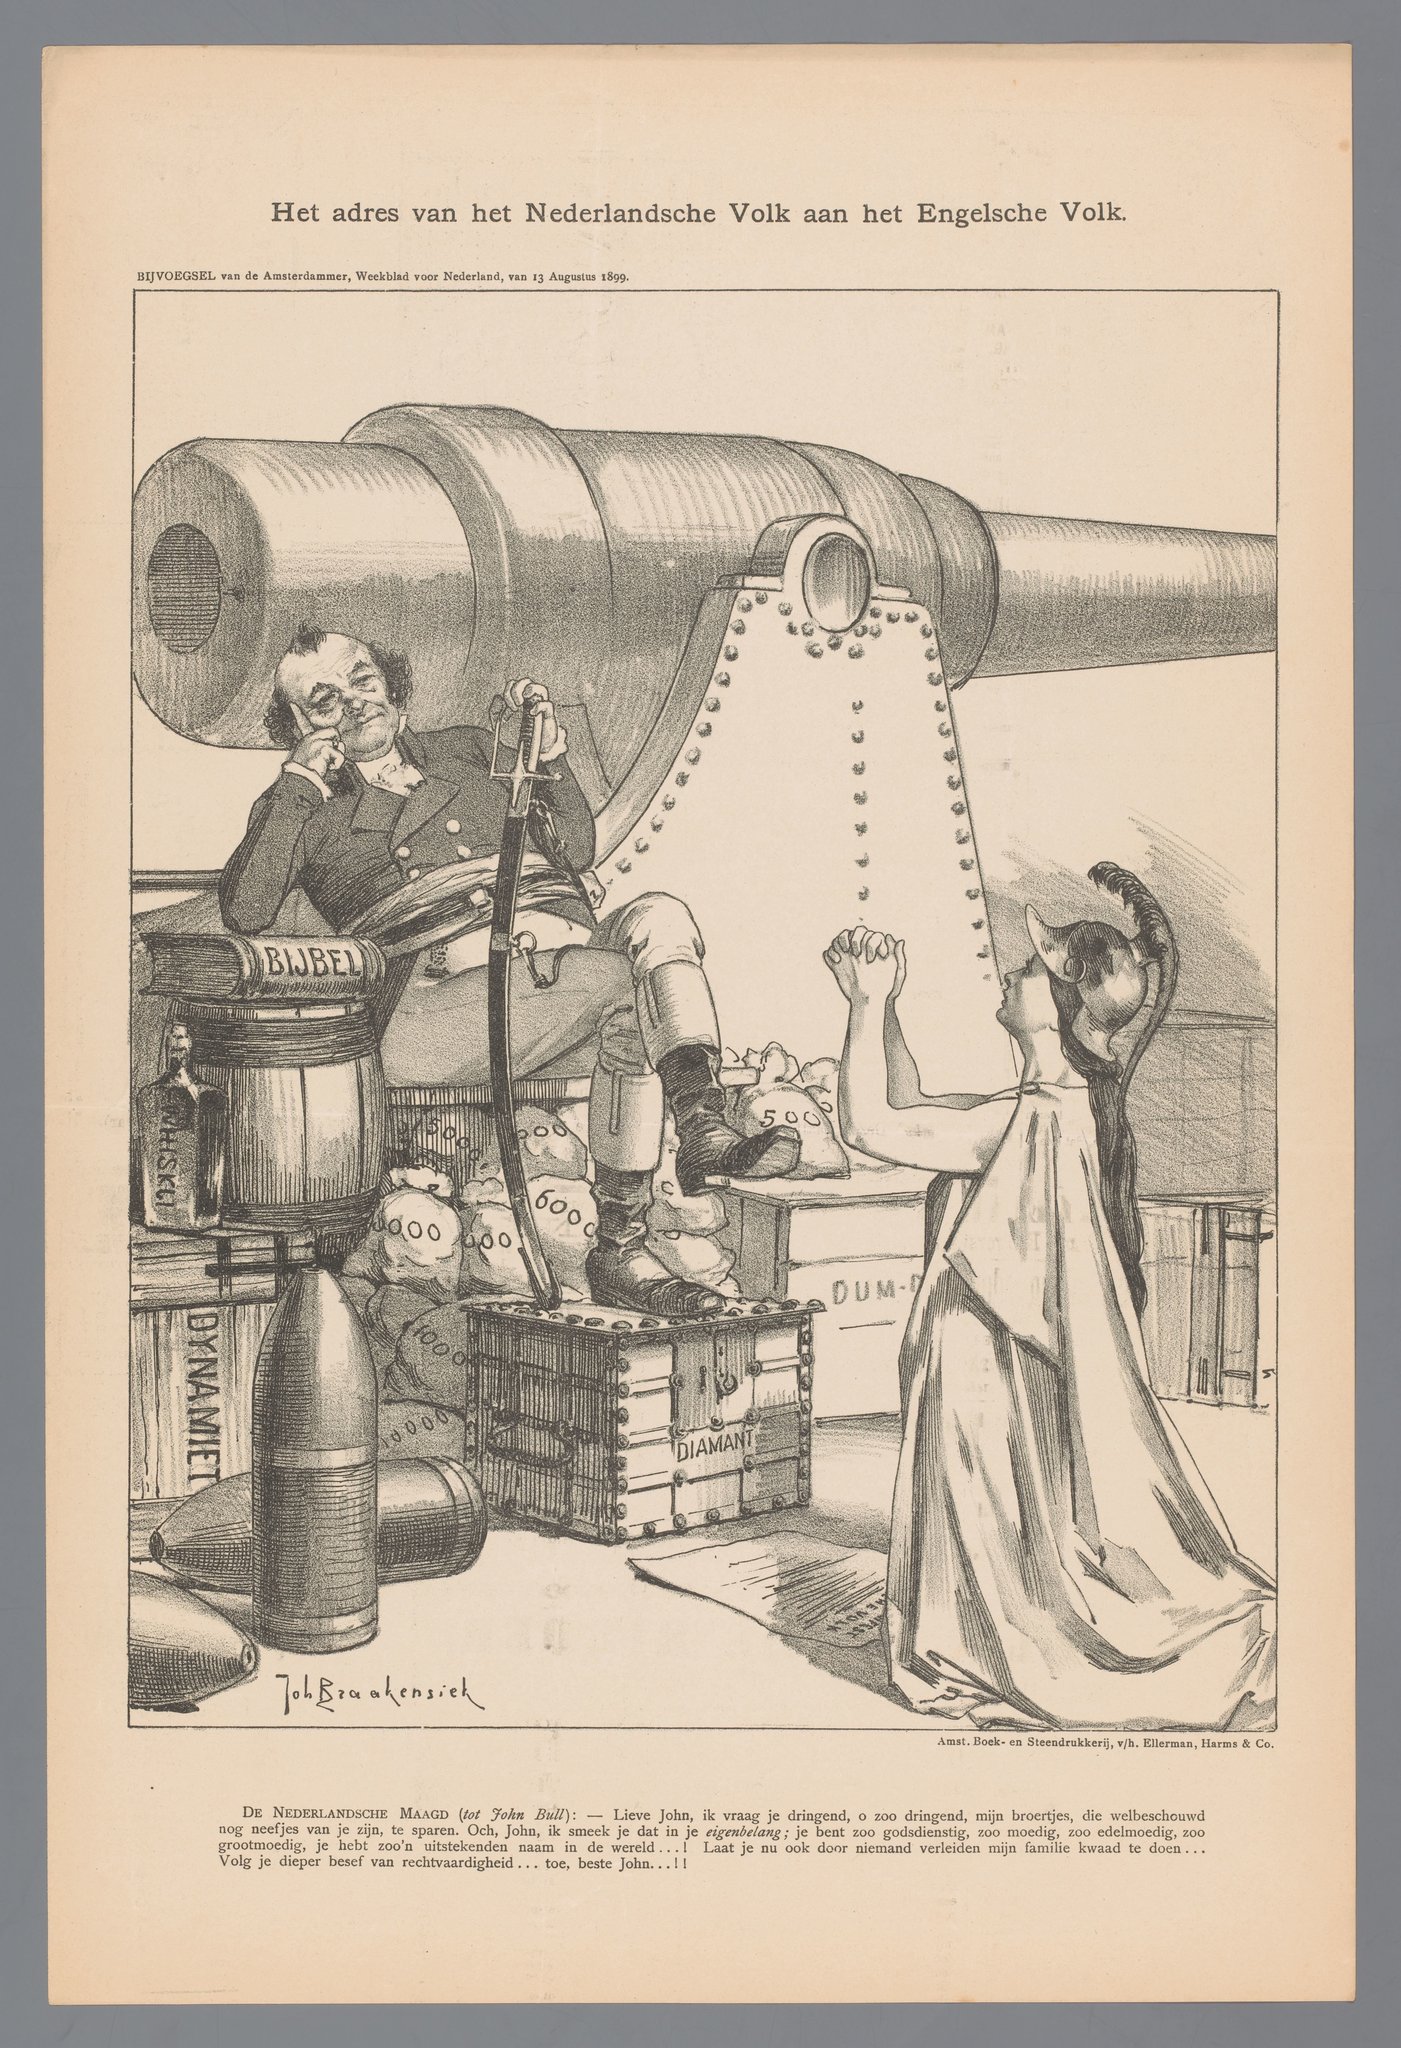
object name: cartoon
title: Het adres van het Nederlandsche Volk aan het Engelsche Volk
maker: johan braakensiek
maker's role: draughtsman, print maker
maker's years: 1858-1940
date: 1899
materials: paper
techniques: lithograph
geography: amsterdam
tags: ammunition, personifications of countries, nations, states, districts, etc., firearms: cannon, political caricatures and satires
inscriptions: date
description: Prent uit het bijvoegsel van: De Amsterdammer. Weekblad voor Nederland, 13 augustus 1899.